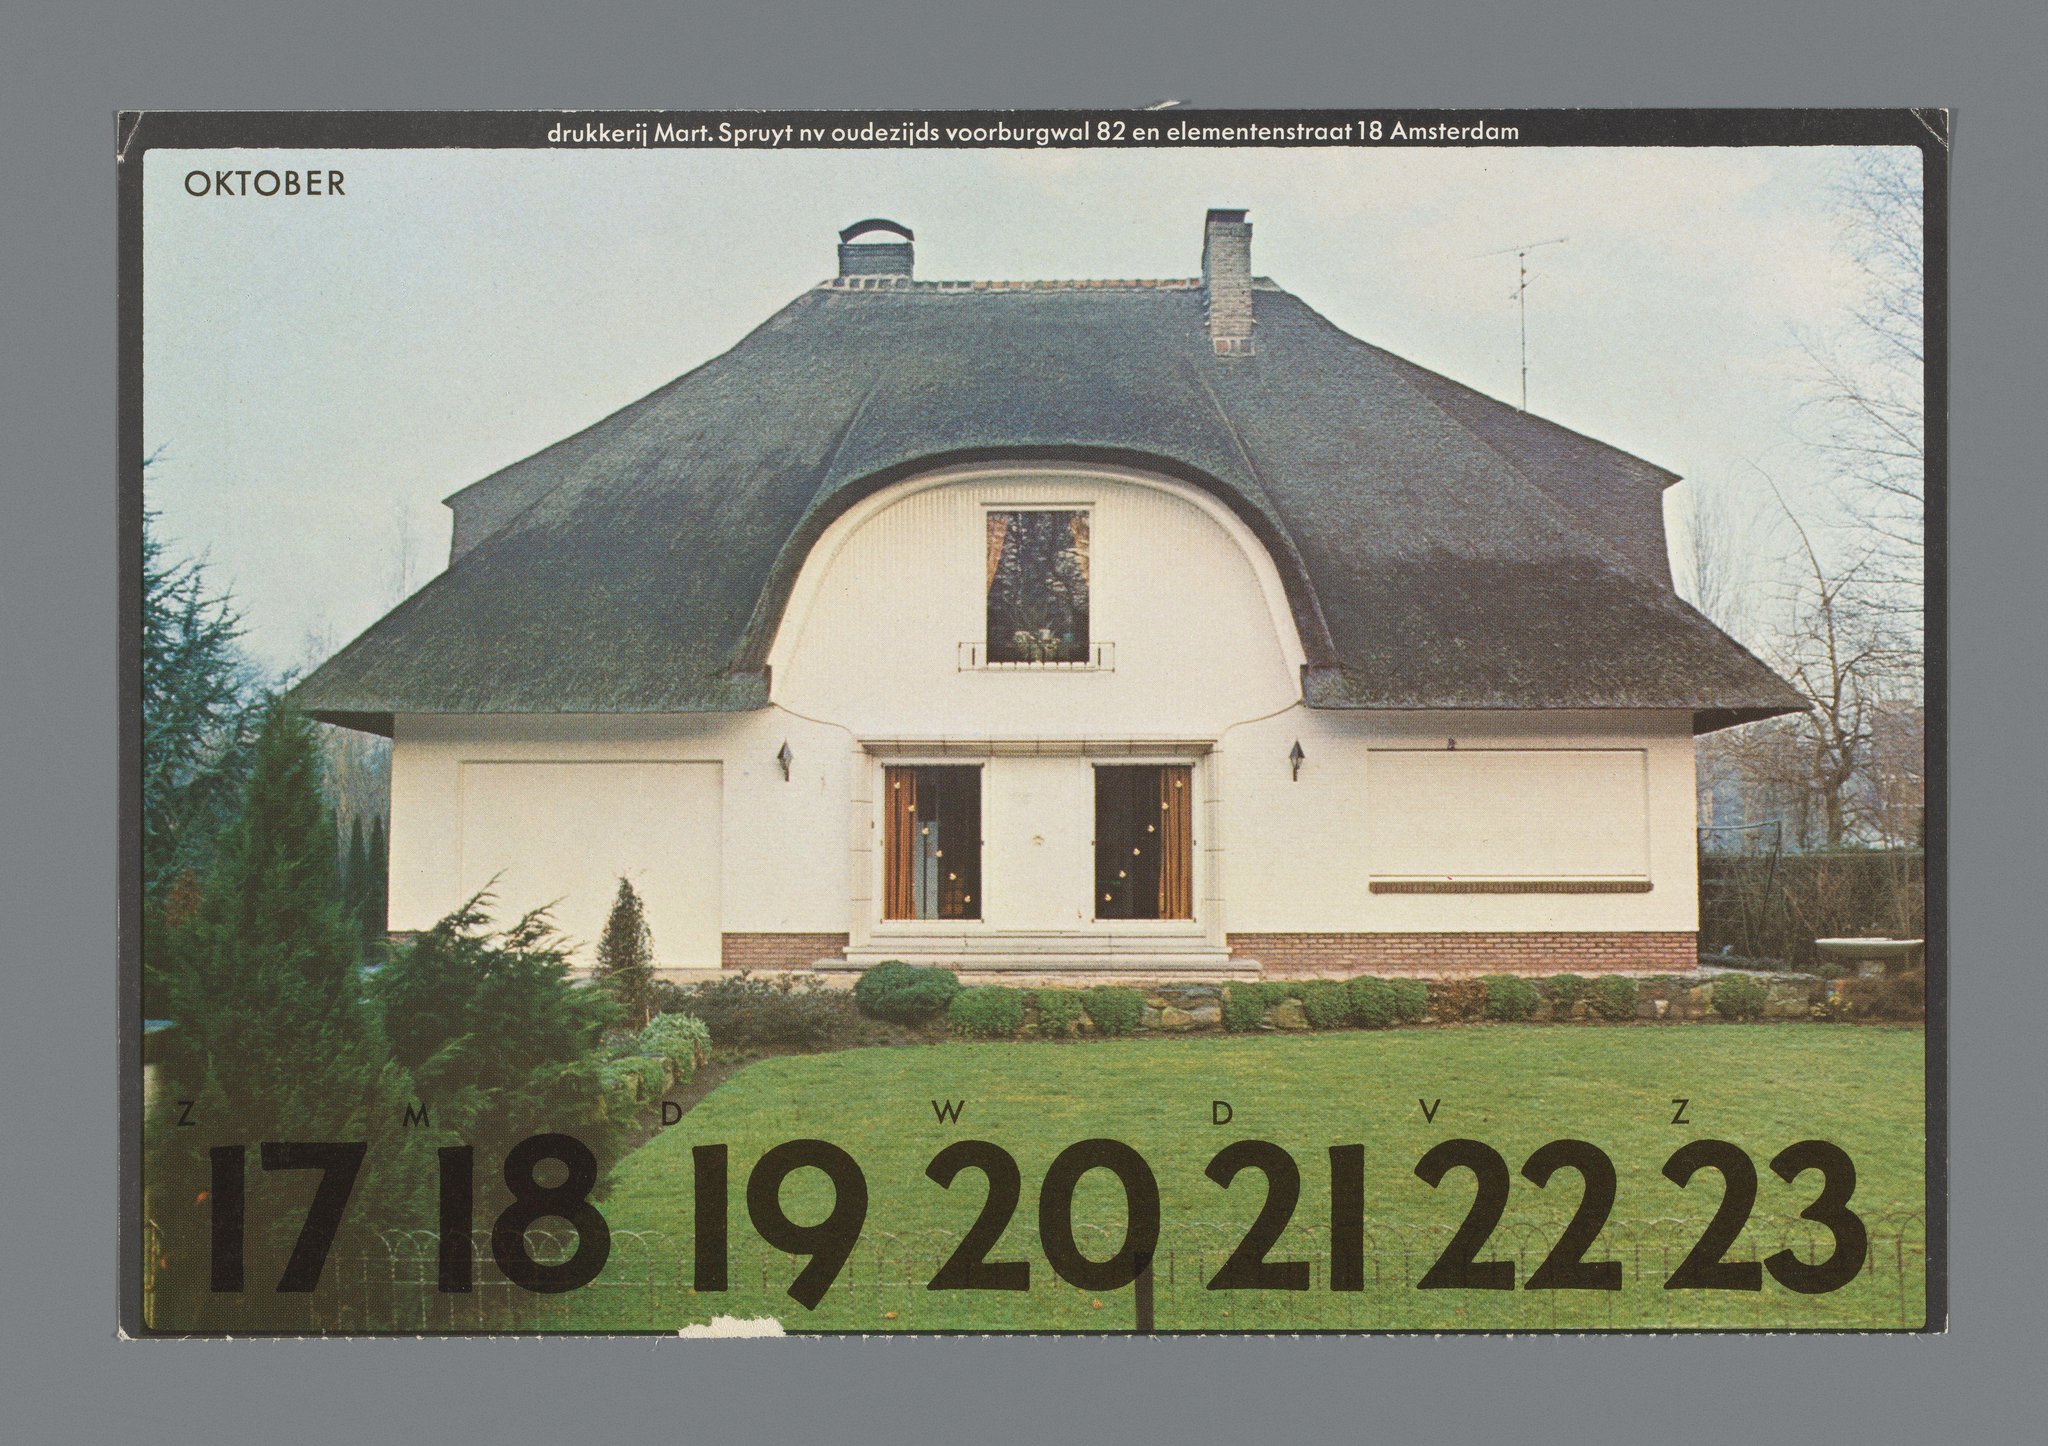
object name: photograph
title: België. Huizen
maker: Anonymous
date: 1900-1950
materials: paper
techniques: offset printed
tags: belgium